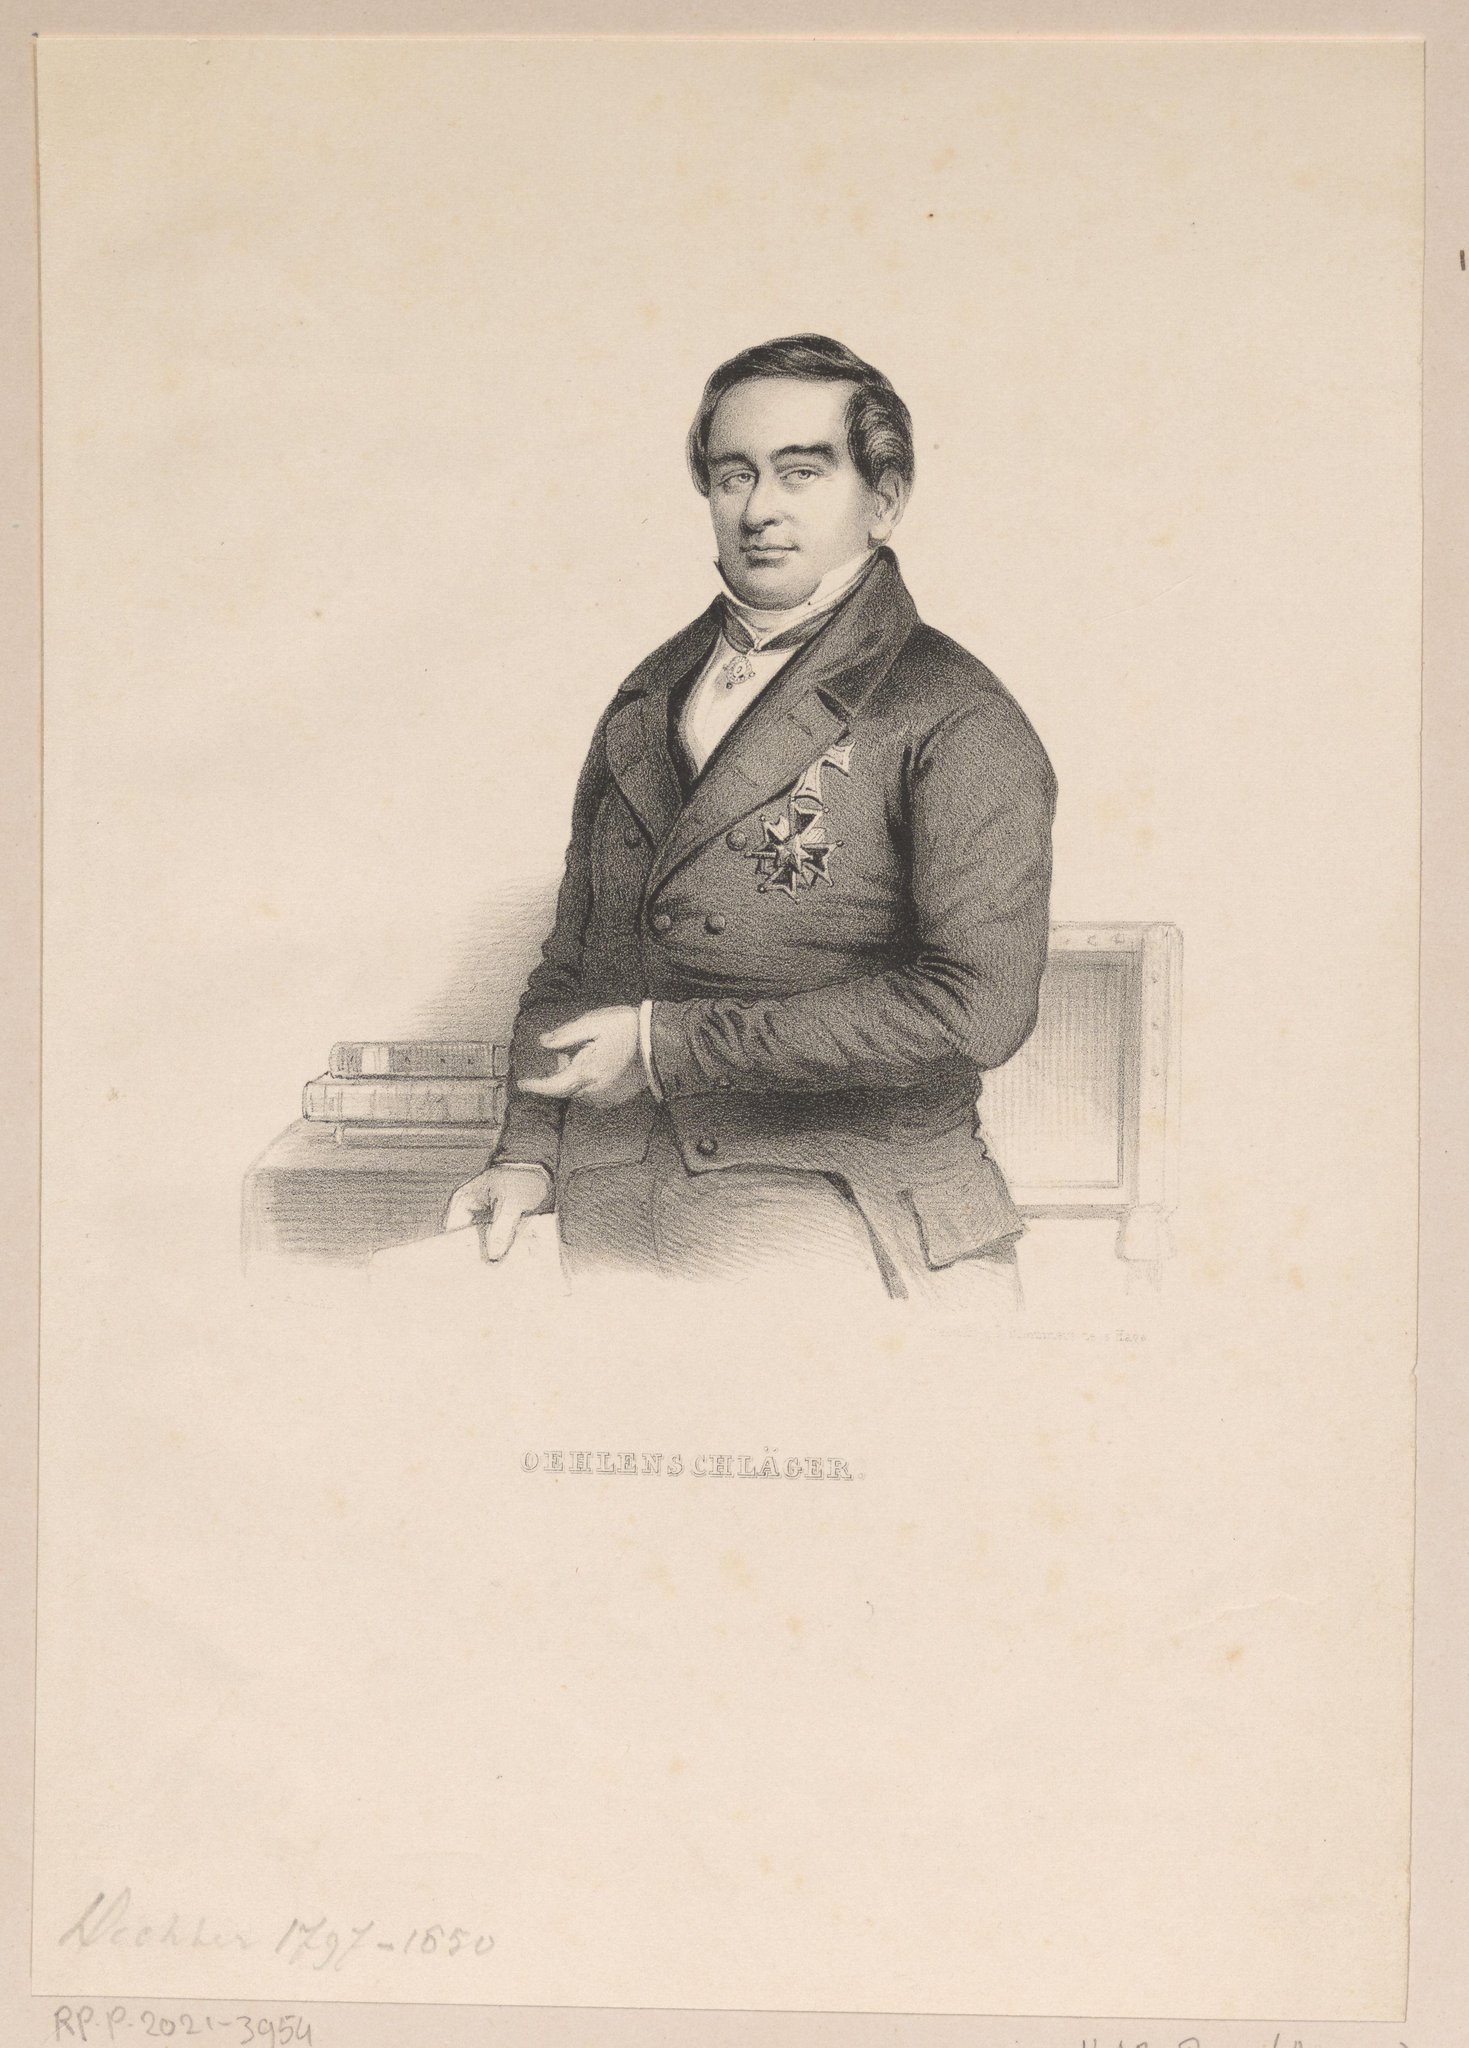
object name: print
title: Portret van Adam Oehlenschläger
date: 1842-1887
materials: paper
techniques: lithograph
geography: the hague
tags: copenhagen (city), adam oehlenschläger, historical persons, book, writer, poet, author